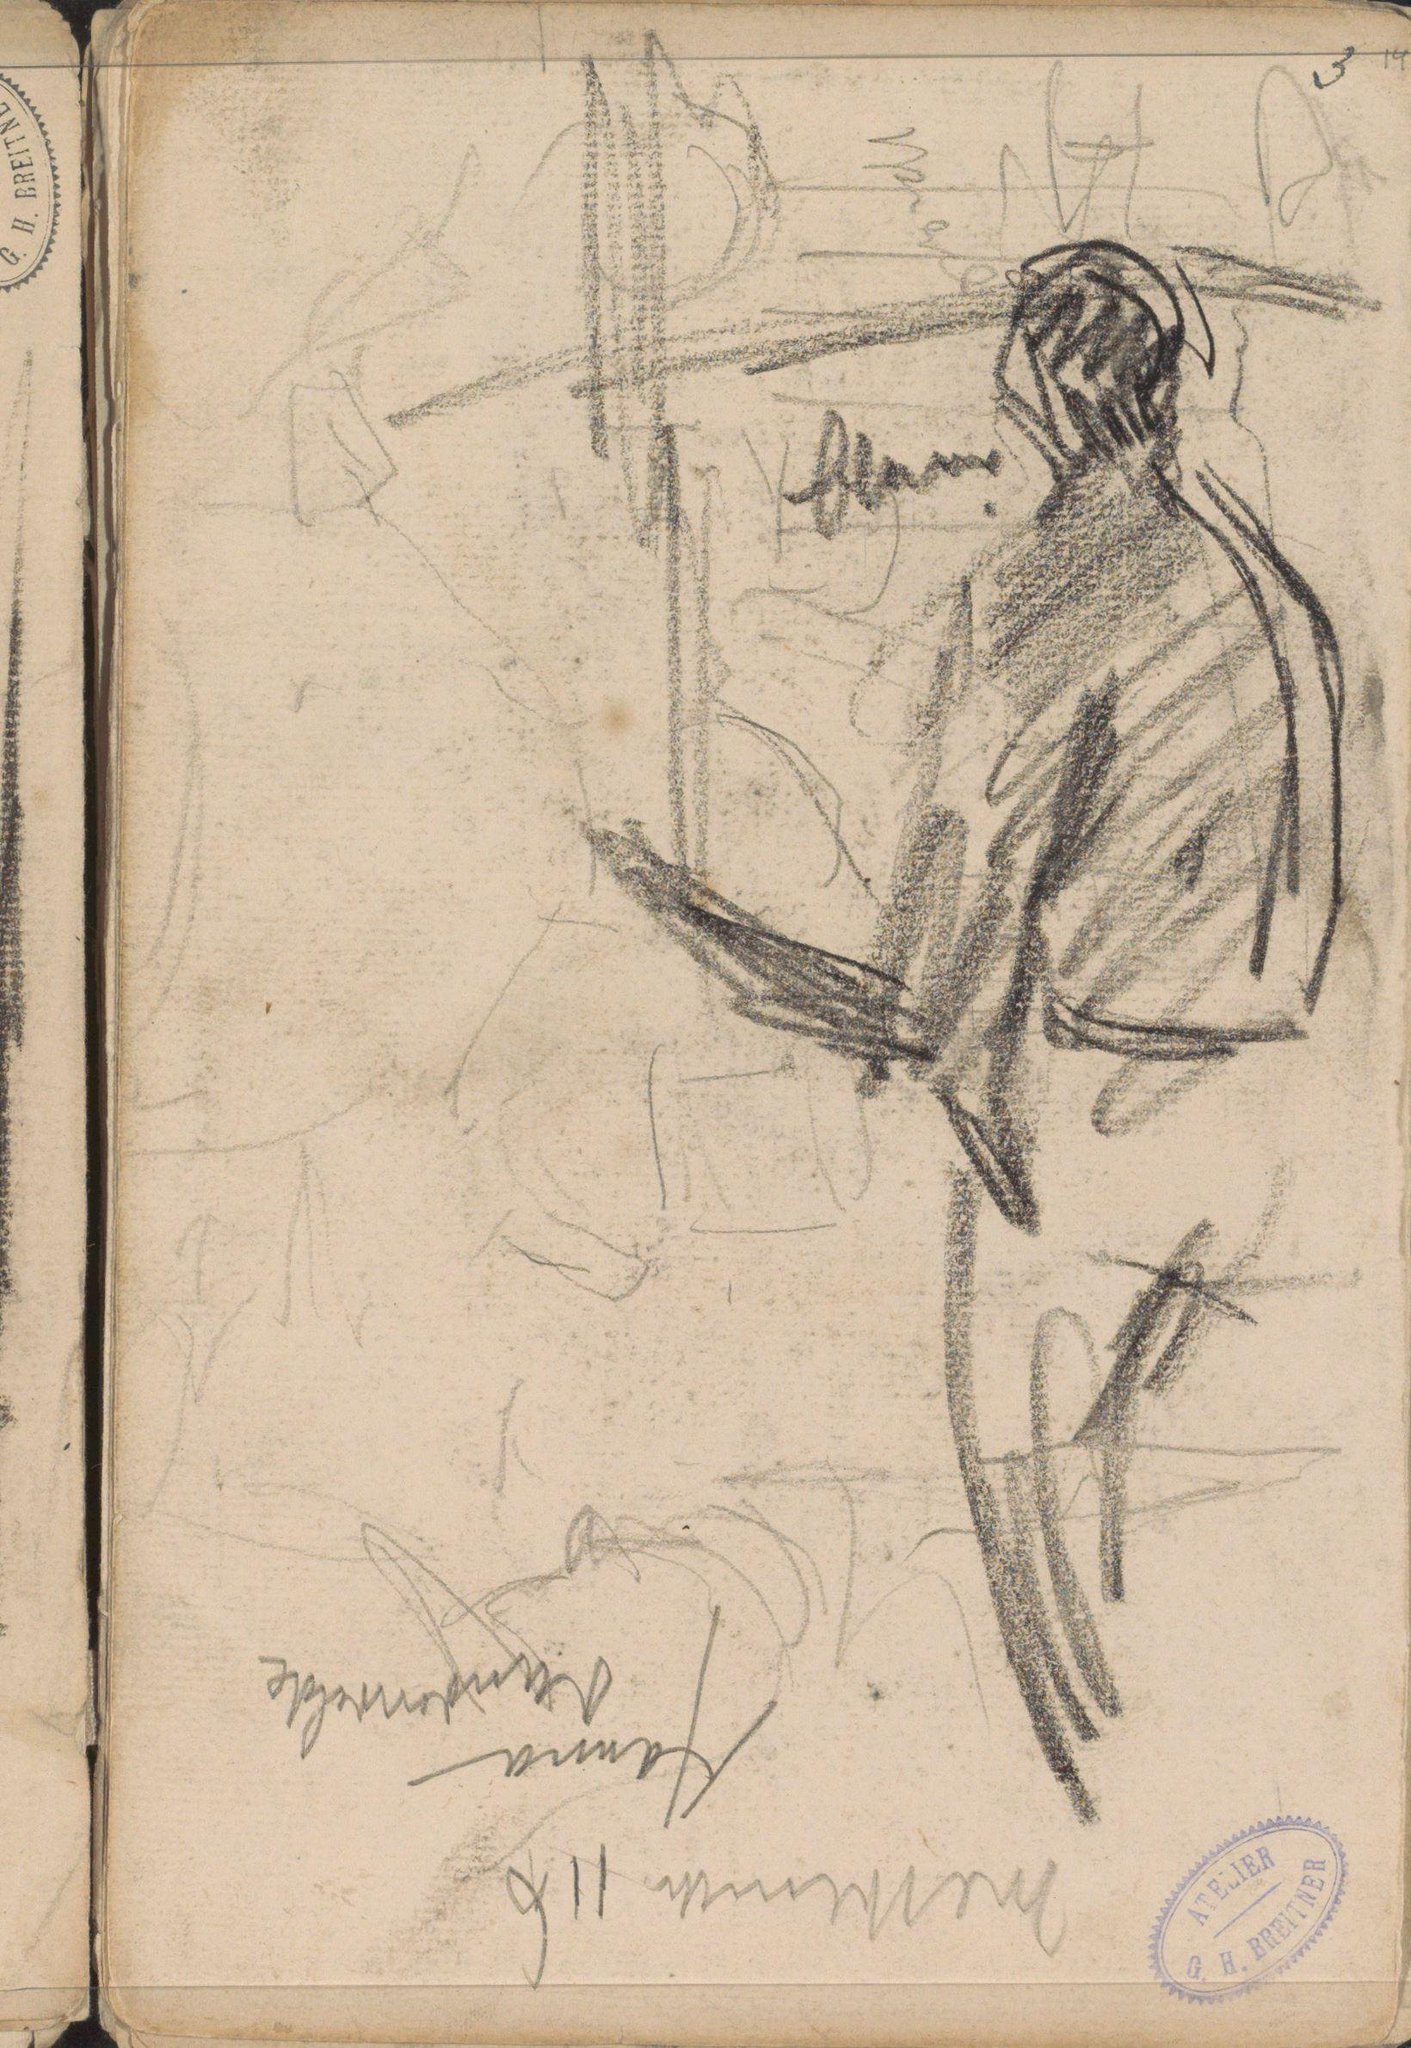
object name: sketchbook leaf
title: Studieblad met mannen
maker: george hendrik breitner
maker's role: draughtsman, painter, print maker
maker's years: 1857-1923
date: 1886-1923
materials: chalk, paper, pencil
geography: amsterdam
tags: standing figure, adult man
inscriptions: workshop stamp: Lugt 291d, annotation: ‘[...]’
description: Pagina 14 uit een schetsboek met 19 bladen en 9 losse tekeningen.